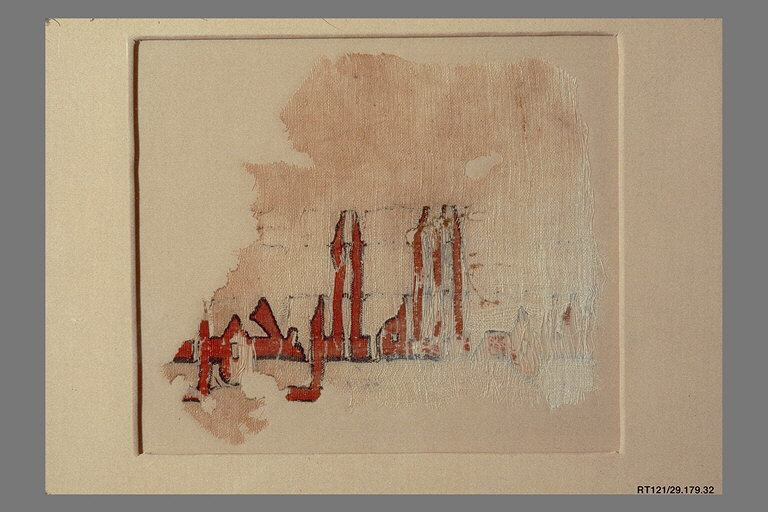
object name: textile fragment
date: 934-966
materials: linen, silk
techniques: weave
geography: egypt